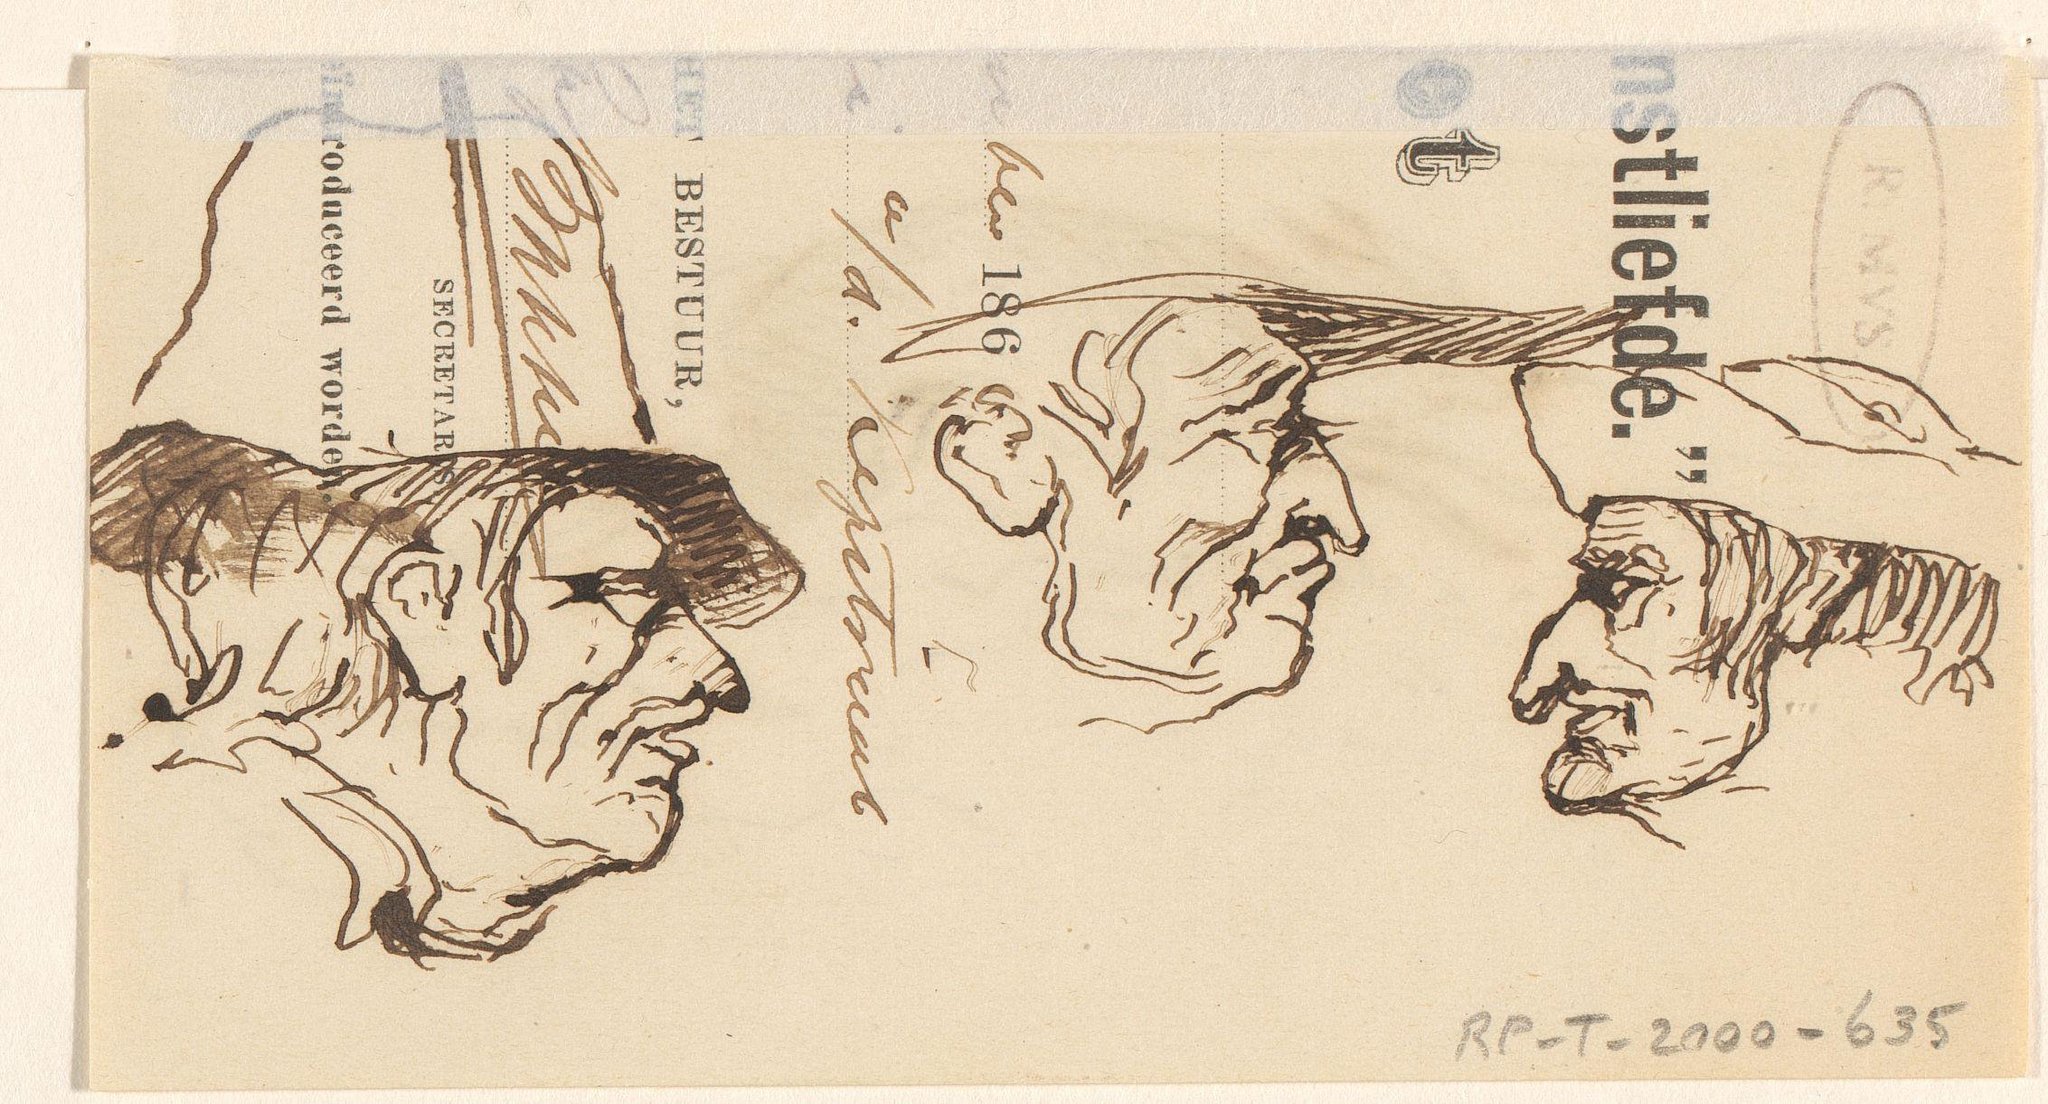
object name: drawing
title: Drie koppen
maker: johannes tavenraat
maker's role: draughtsman, painter, print maker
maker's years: 1809-1881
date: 1860-1869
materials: ink, paper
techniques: pen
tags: caricatures (human types)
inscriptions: collector's mark: Lugt 2228, signature: ‘Tavenraat’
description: Drie koppen. Getekend op een stuk van een drukwerk met jaartal 186...